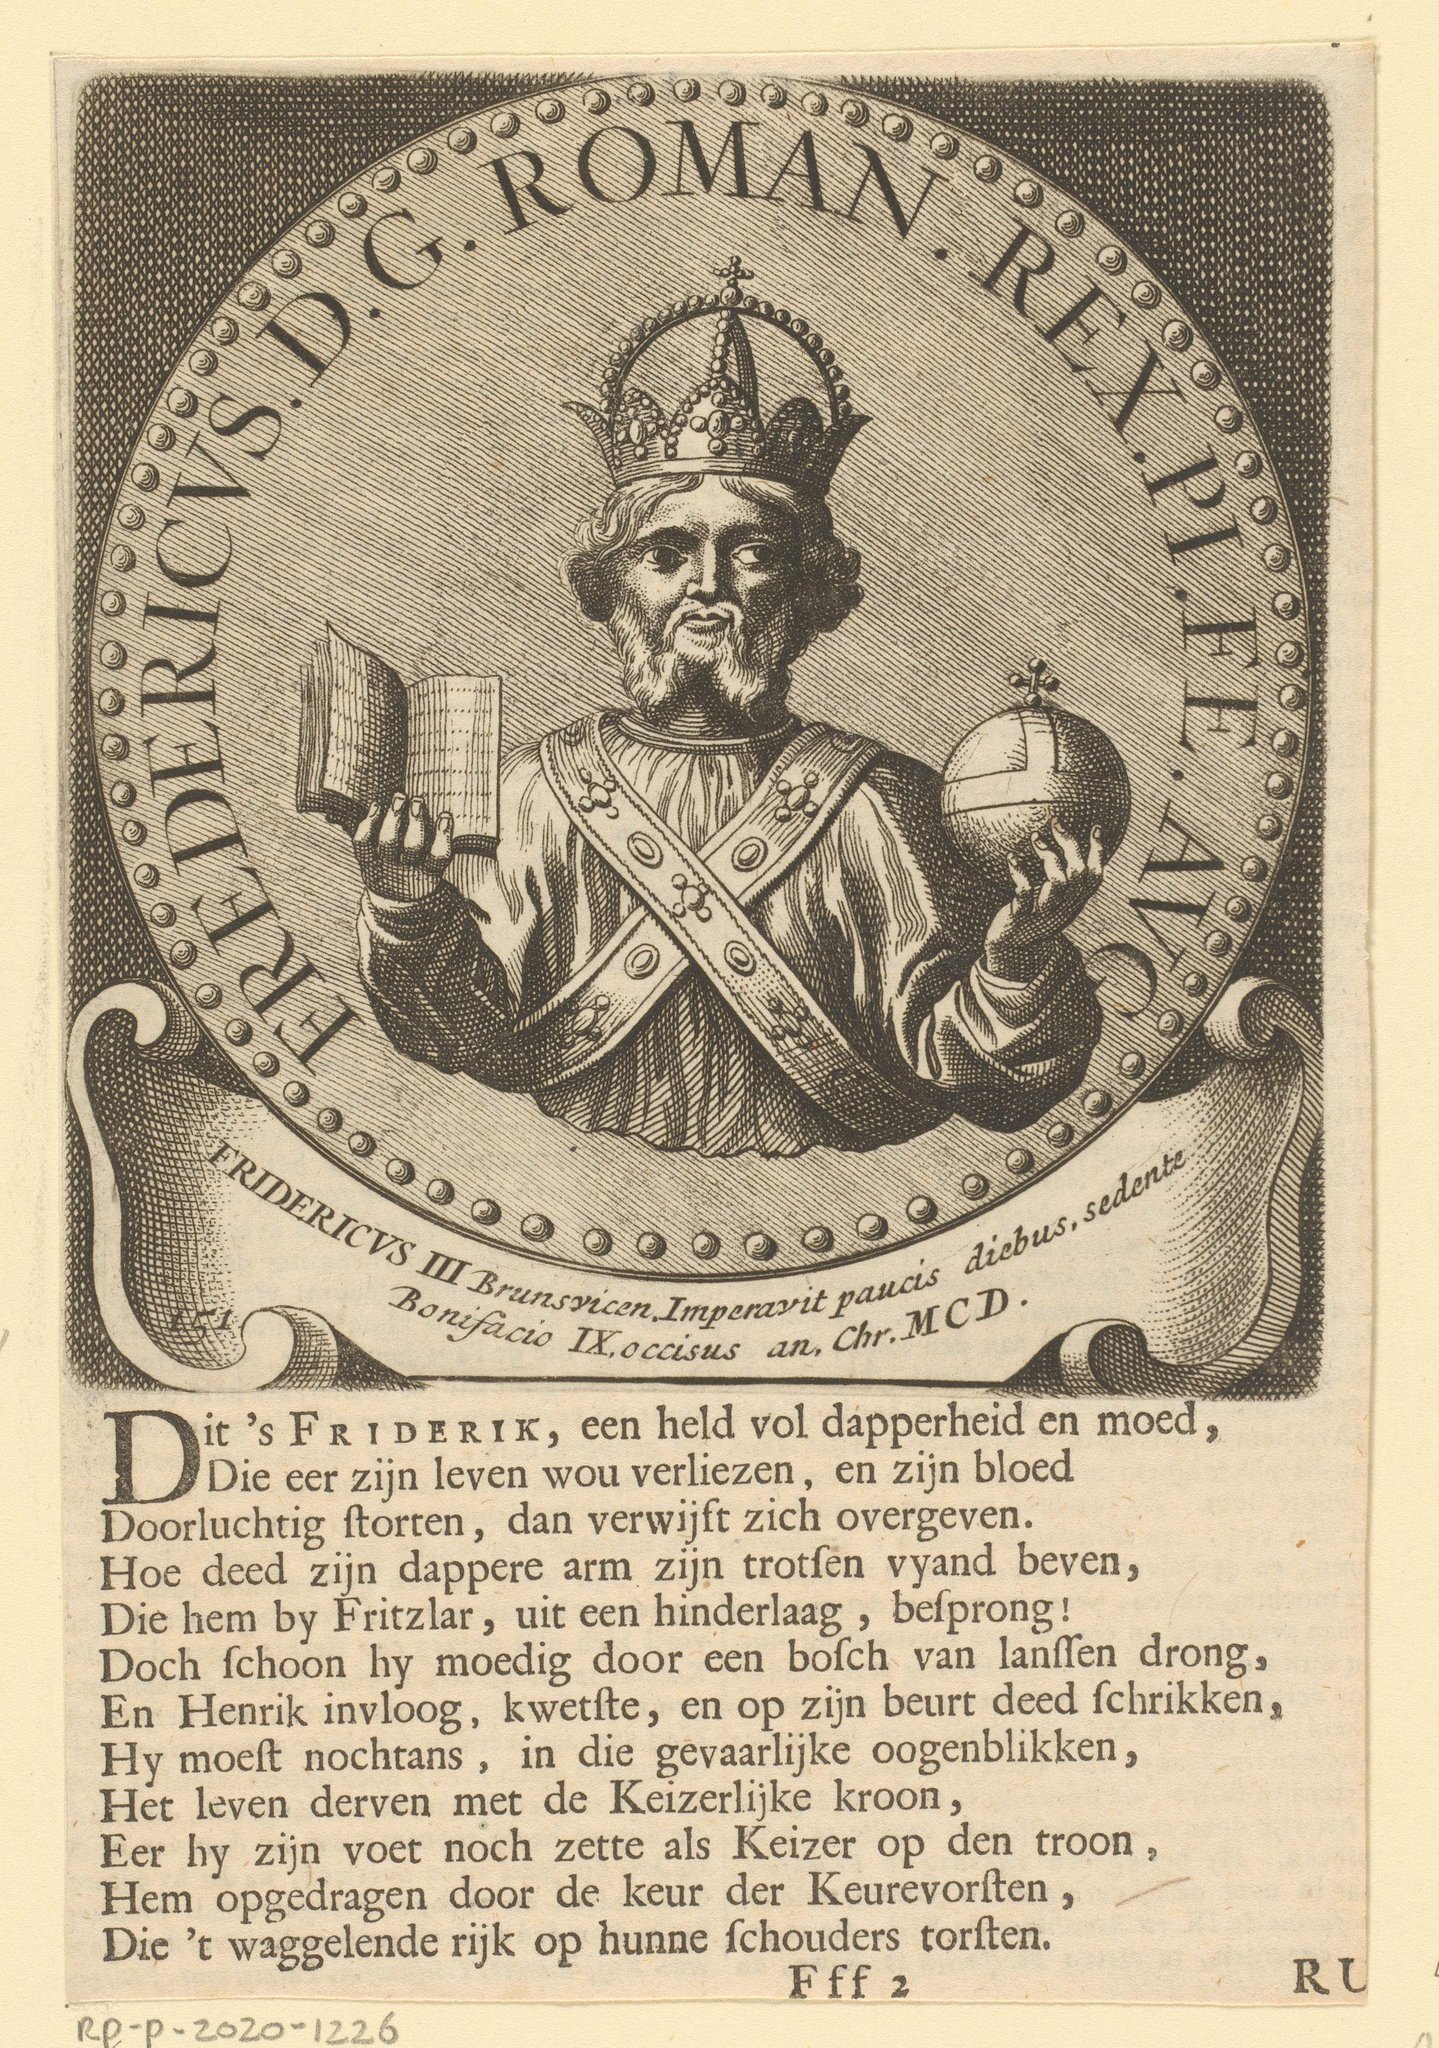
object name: print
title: Fredericus. d.g. Roman. rex. pi. fe. Aug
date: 1697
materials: paper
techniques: engraving, etching, letterpress printing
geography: utrecht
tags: crown (symbol of sovereignty), historical persons, book - mm - book open, emperor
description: Prent uit: Bogaert, Abraham. De Roomsche monarchy, vertoont in de muntbeelden der westersche en oostersche keizeren (...). Utrecht: François Halma en Willem van de Water, 1697, p. 411. Eerste staat verschenen als grotere prent met 12 portretten, gedateerd 1695.